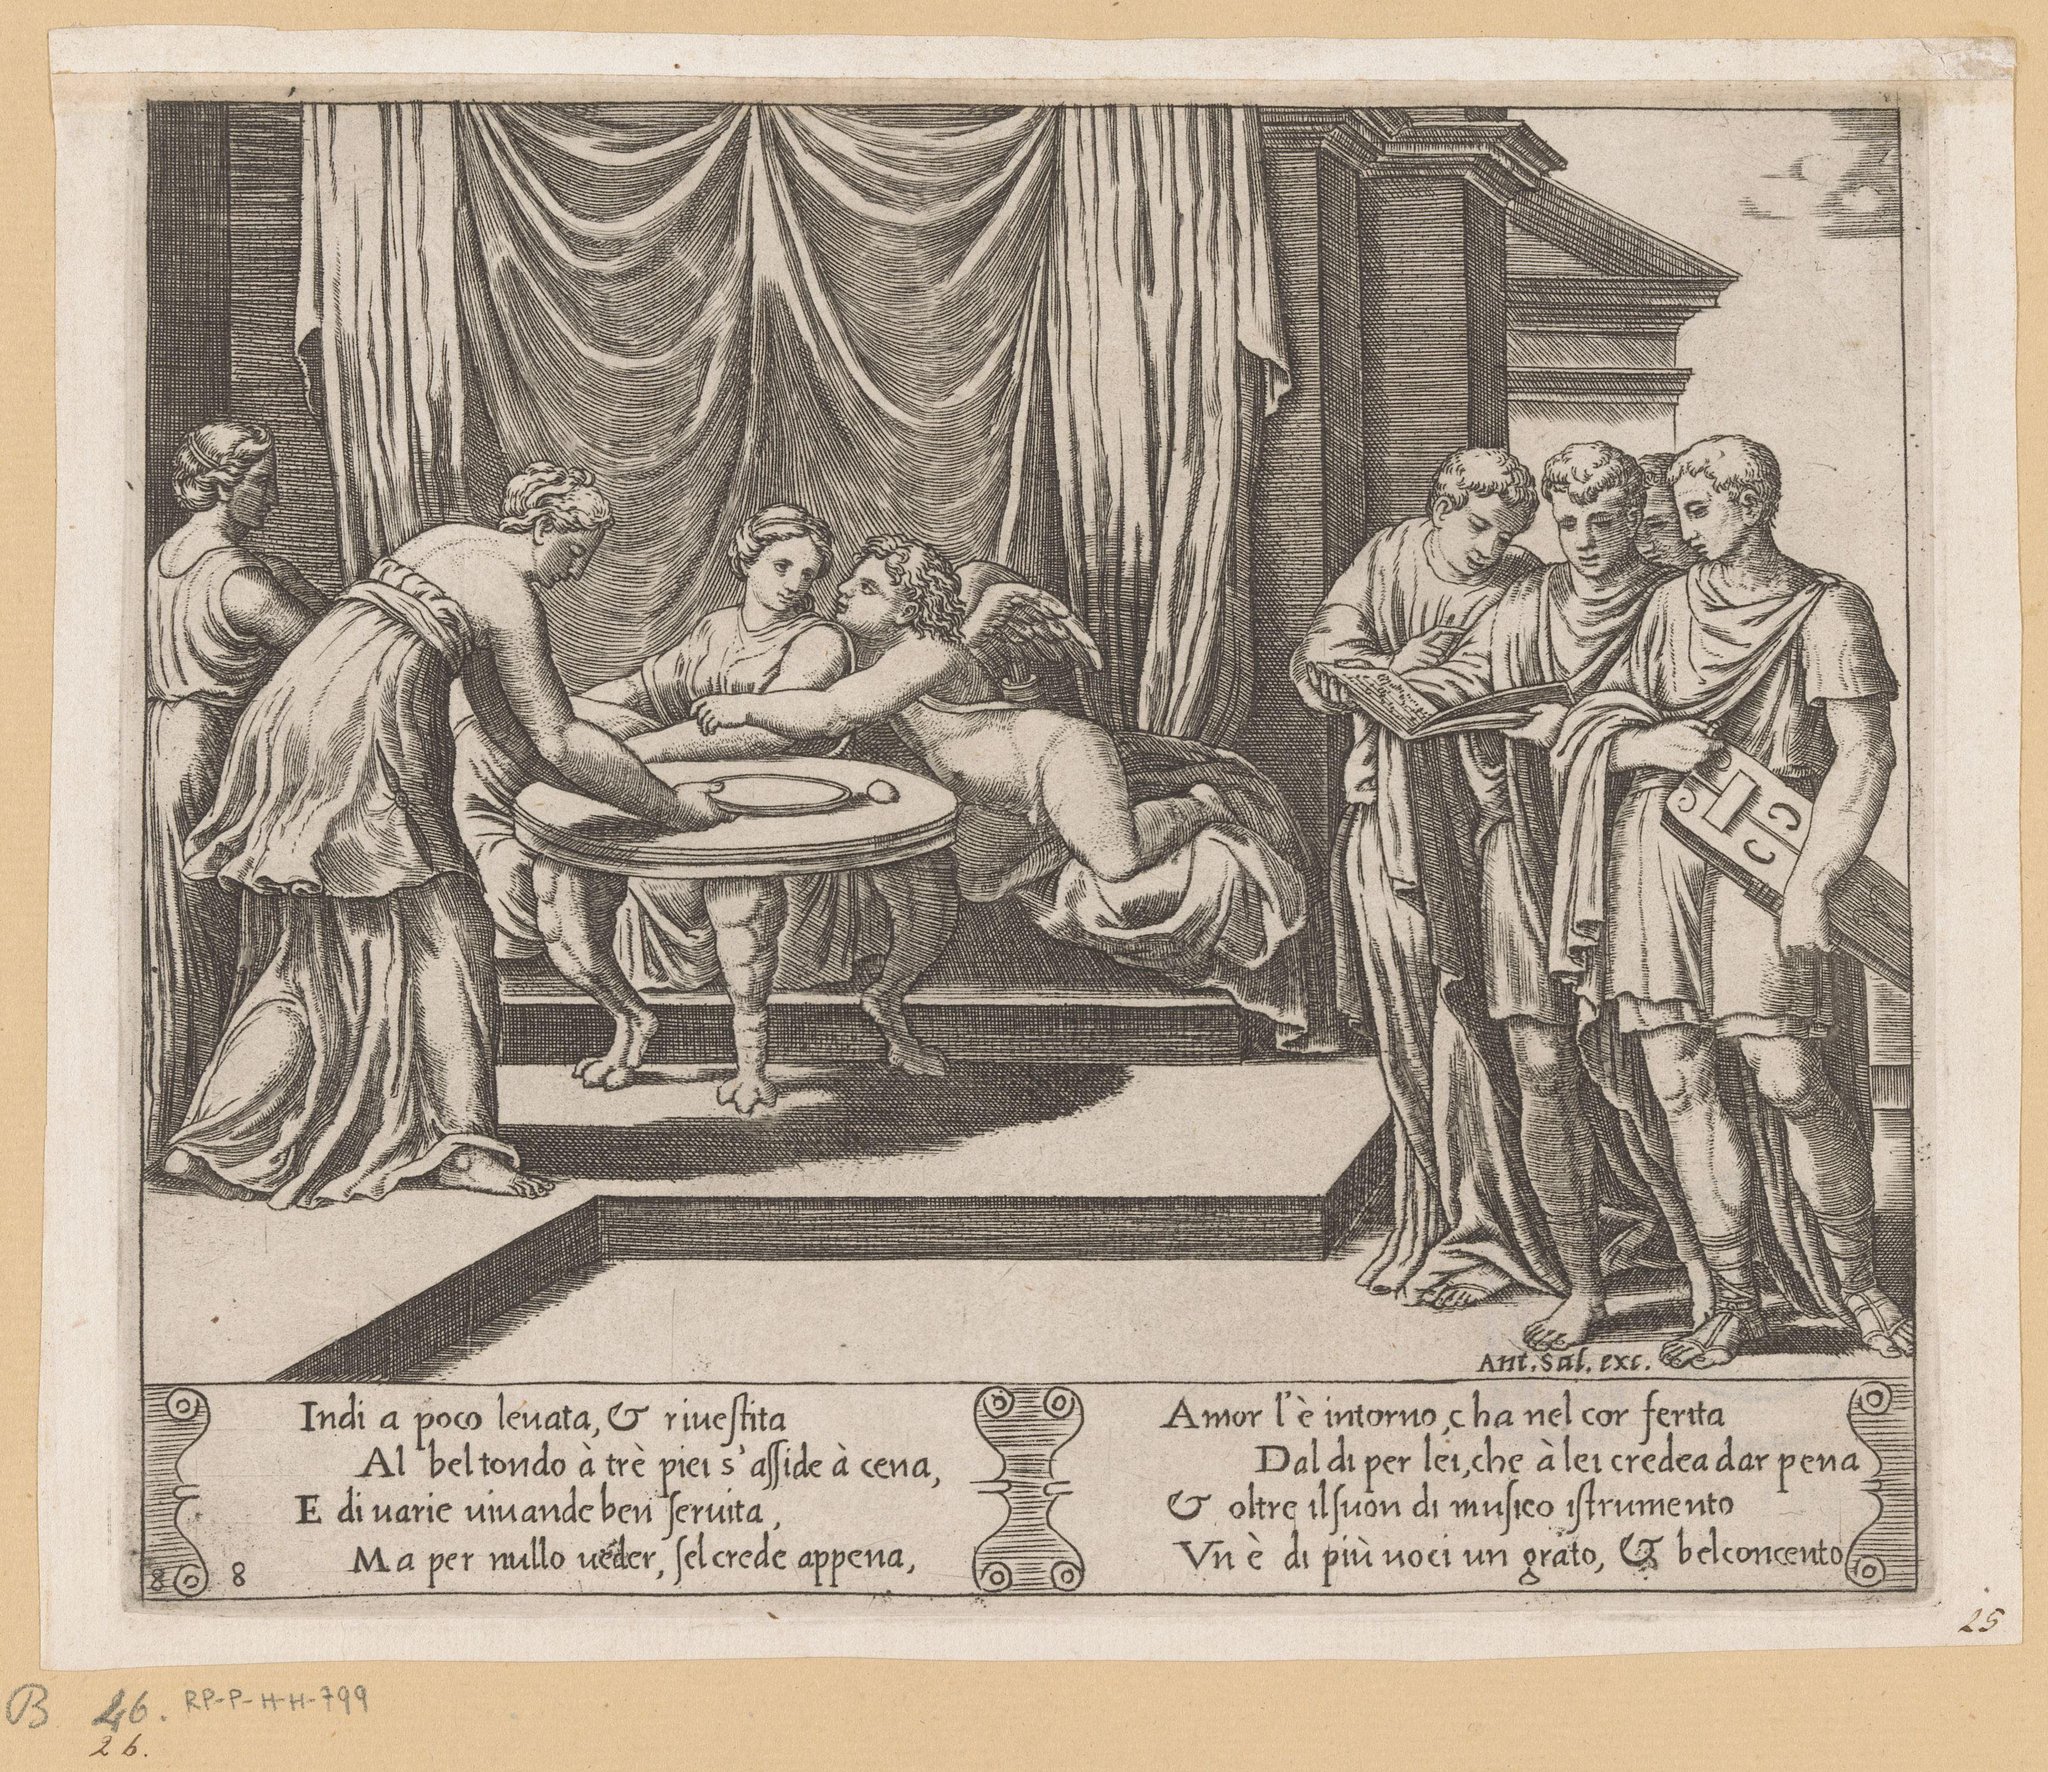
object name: print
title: Verhaal van Amor en Psyche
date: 1530-1560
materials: paper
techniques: engraving, intaglio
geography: italy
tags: psyche is attended by invisible hands; the toilet of psyche, psyche in cupid's palace, hurdy-gurdy, vocal music, singing, cupid and psyche as lovers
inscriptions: collector's mark: Lugt 11, collector's mark: ‘Hinloopen’, number: ‘25’, collector's mark: Lugt 10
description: Amor en Psyche op bed in het paleis van Amor. Rechts vier muzikanten met een liedboek en een draailier. Italiaanse tekst in twee cartouches in ondermarge. Tweemaal genummerd linksonder: 8.